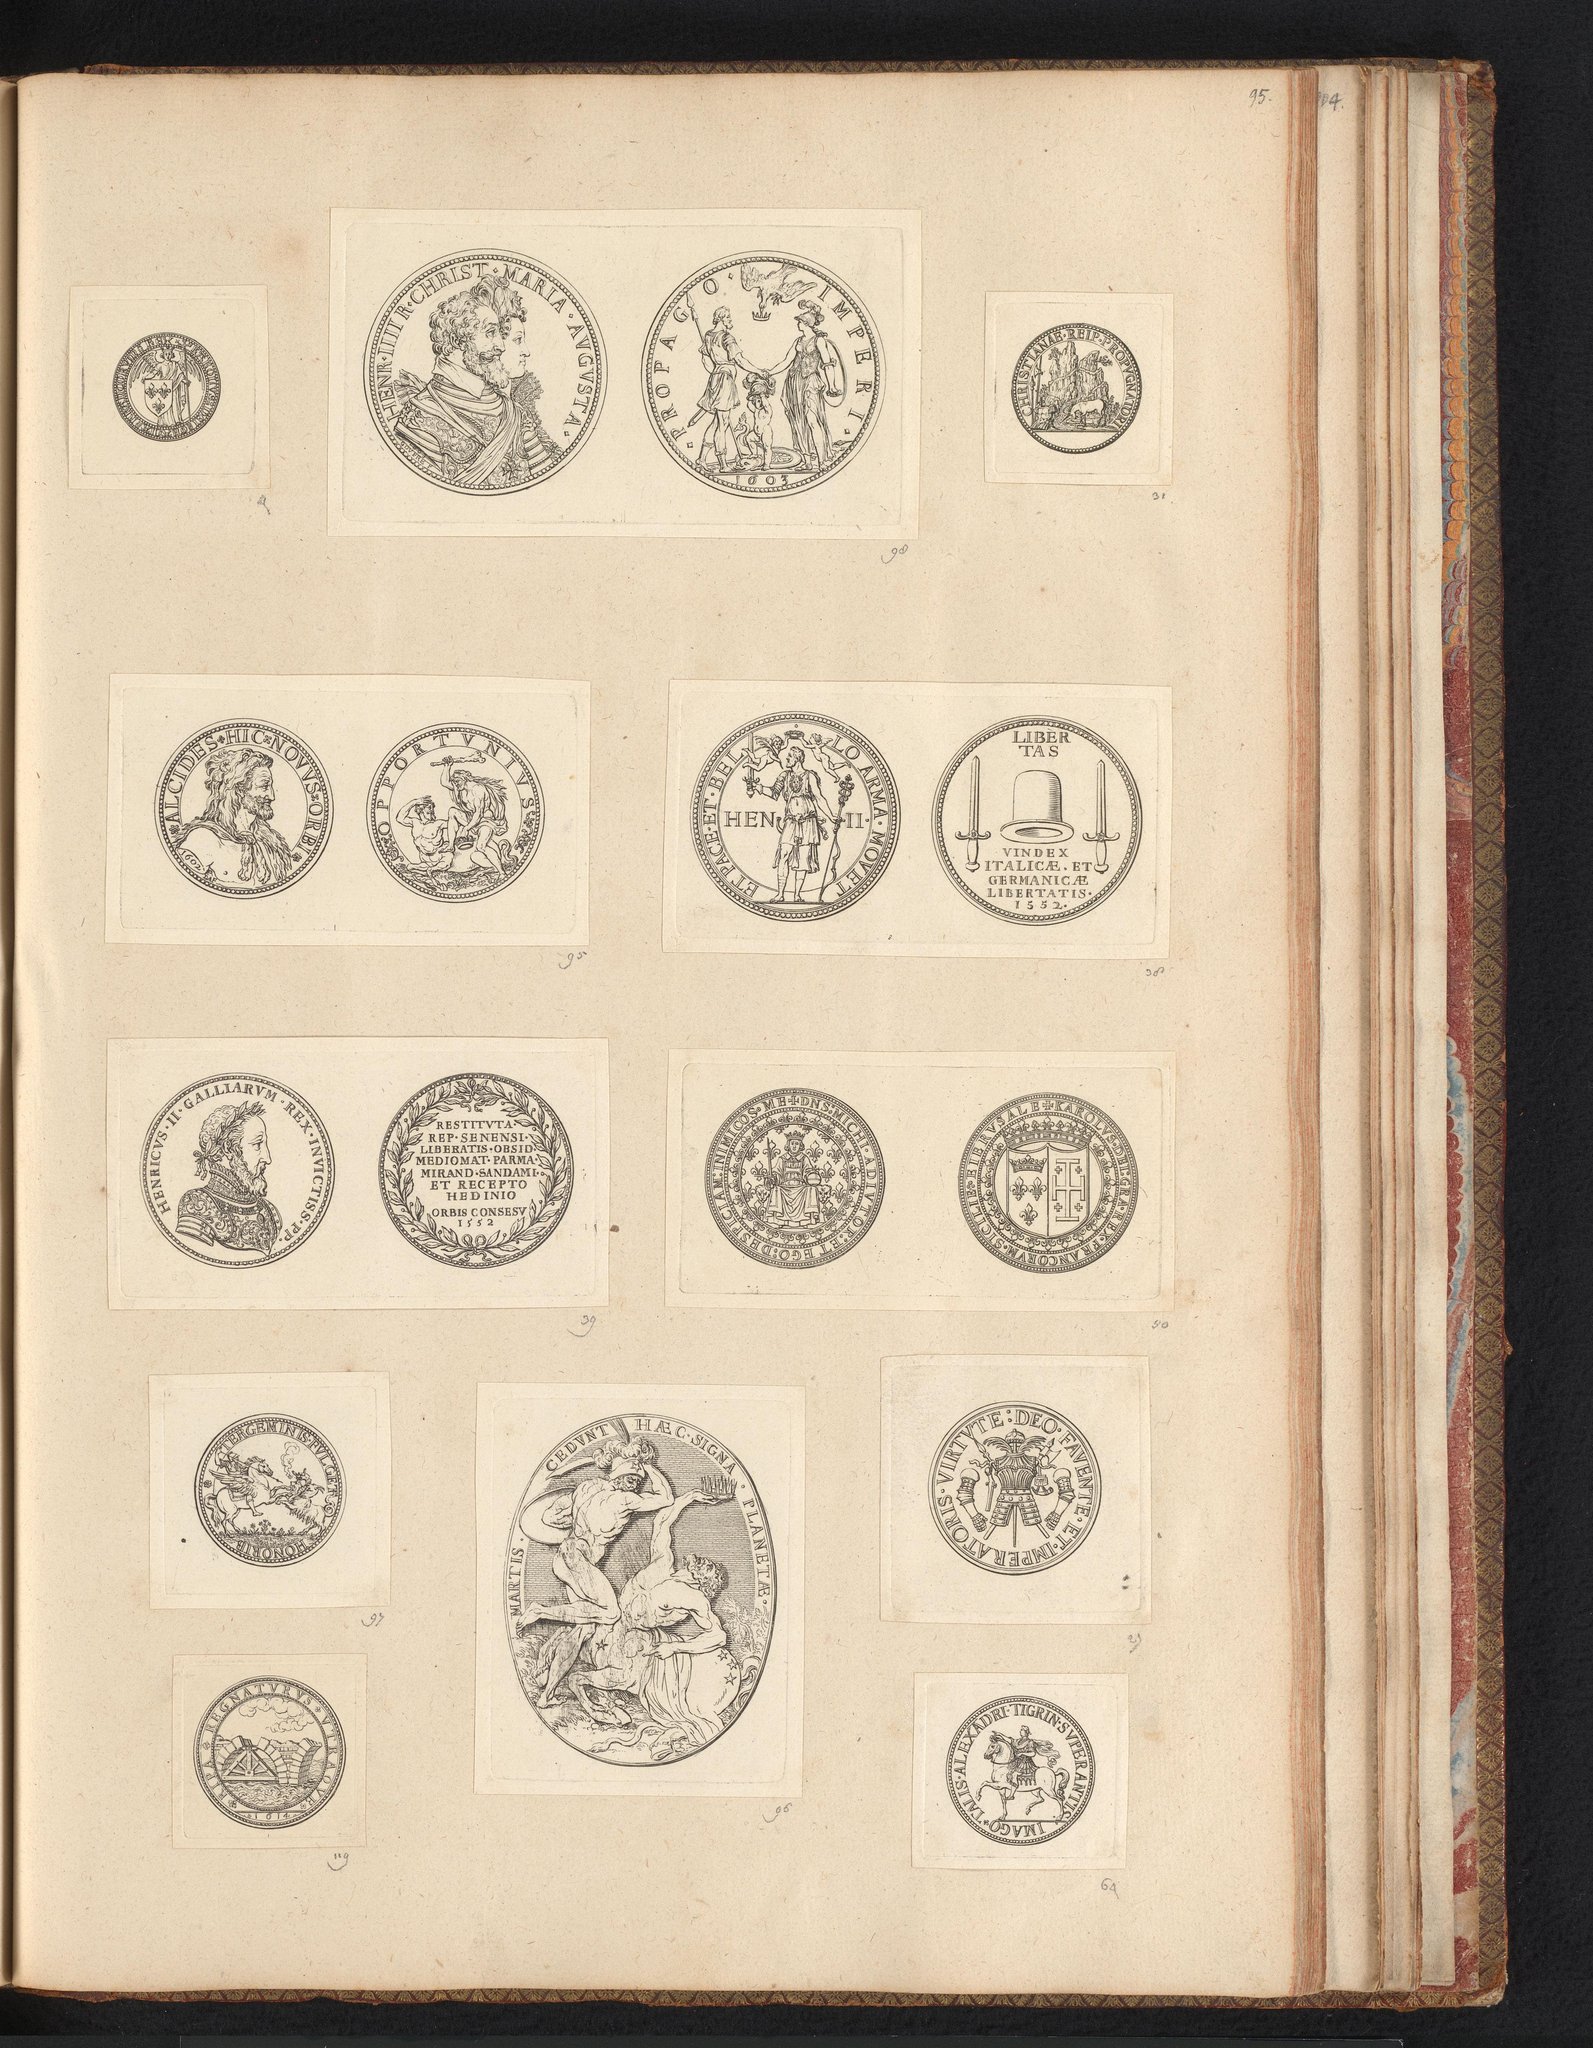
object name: album leaf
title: Medailles met de geschiedenis van Frankrijk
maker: sébastien leclerc (i)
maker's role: print maker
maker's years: 1637-1714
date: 1685-1688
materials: paper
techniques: etching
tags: cologne, maria de' medici, hendrik iv (koning van frankrijk en navarra), (story of) hercules (heracles), centaurs, (story of) mars (ares), historical persons, medal (considered as a piece of sculpture, regardless of its specific function), ranks ~ rulers, sovereigns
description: Twaalf medailles met voorstellingen gerelateerd aan de geschiedenis van Frankrijk. Prenten maken deel uit van een album.